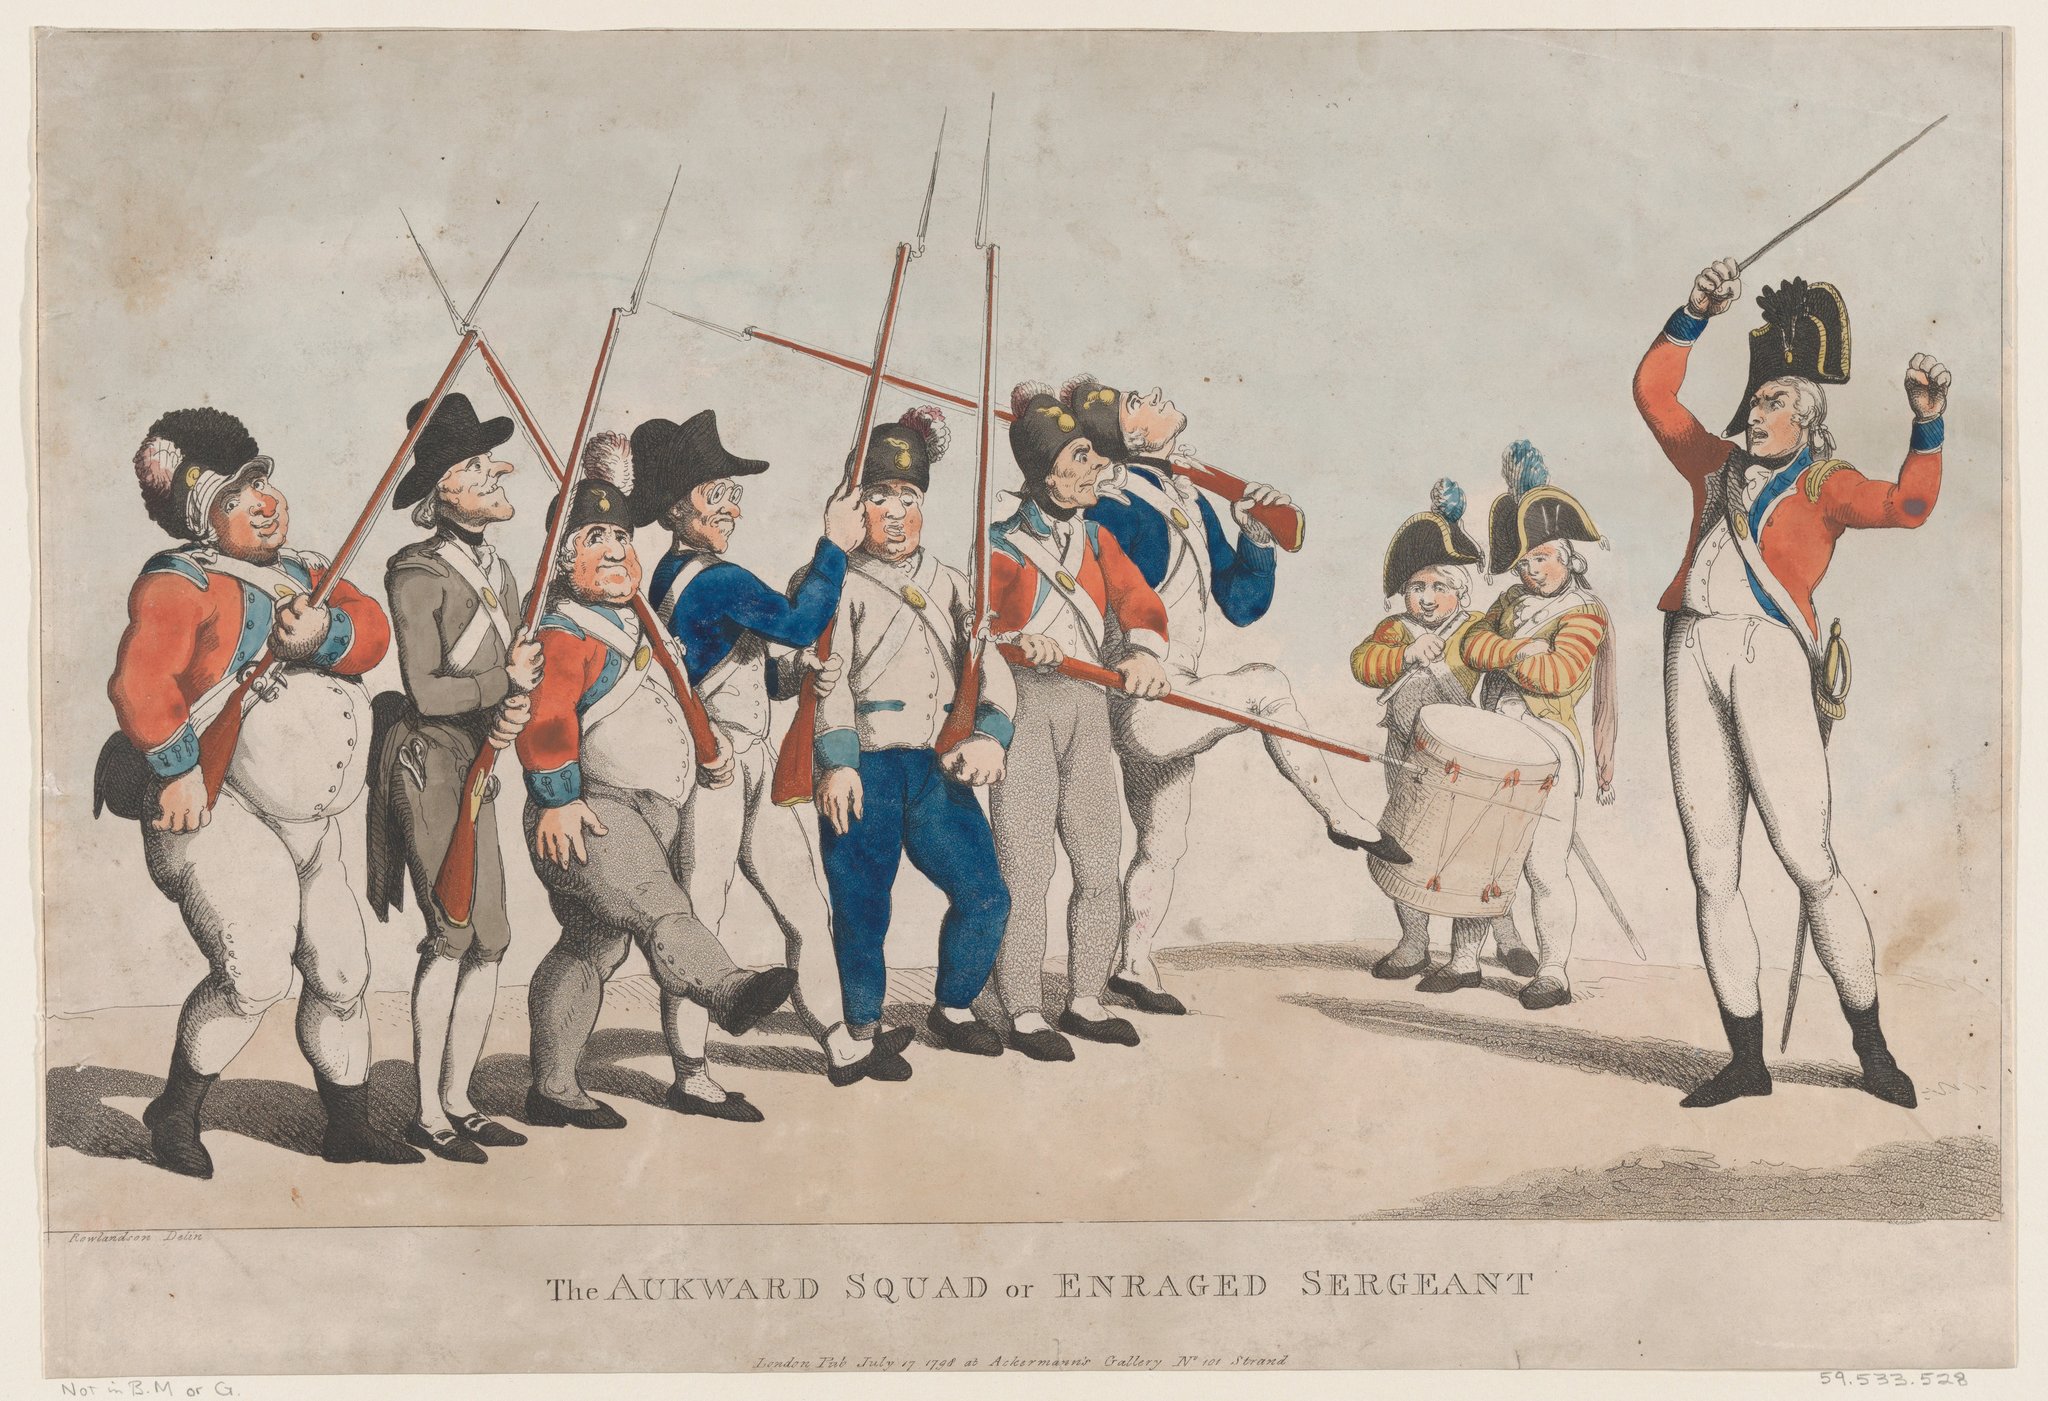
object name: print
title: The Awkward Squad or Enraged Sergeant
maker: thomas rowlandson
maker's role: artist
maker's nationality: british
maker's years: 1757-1827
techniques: etching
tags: satire,military,firearms,men